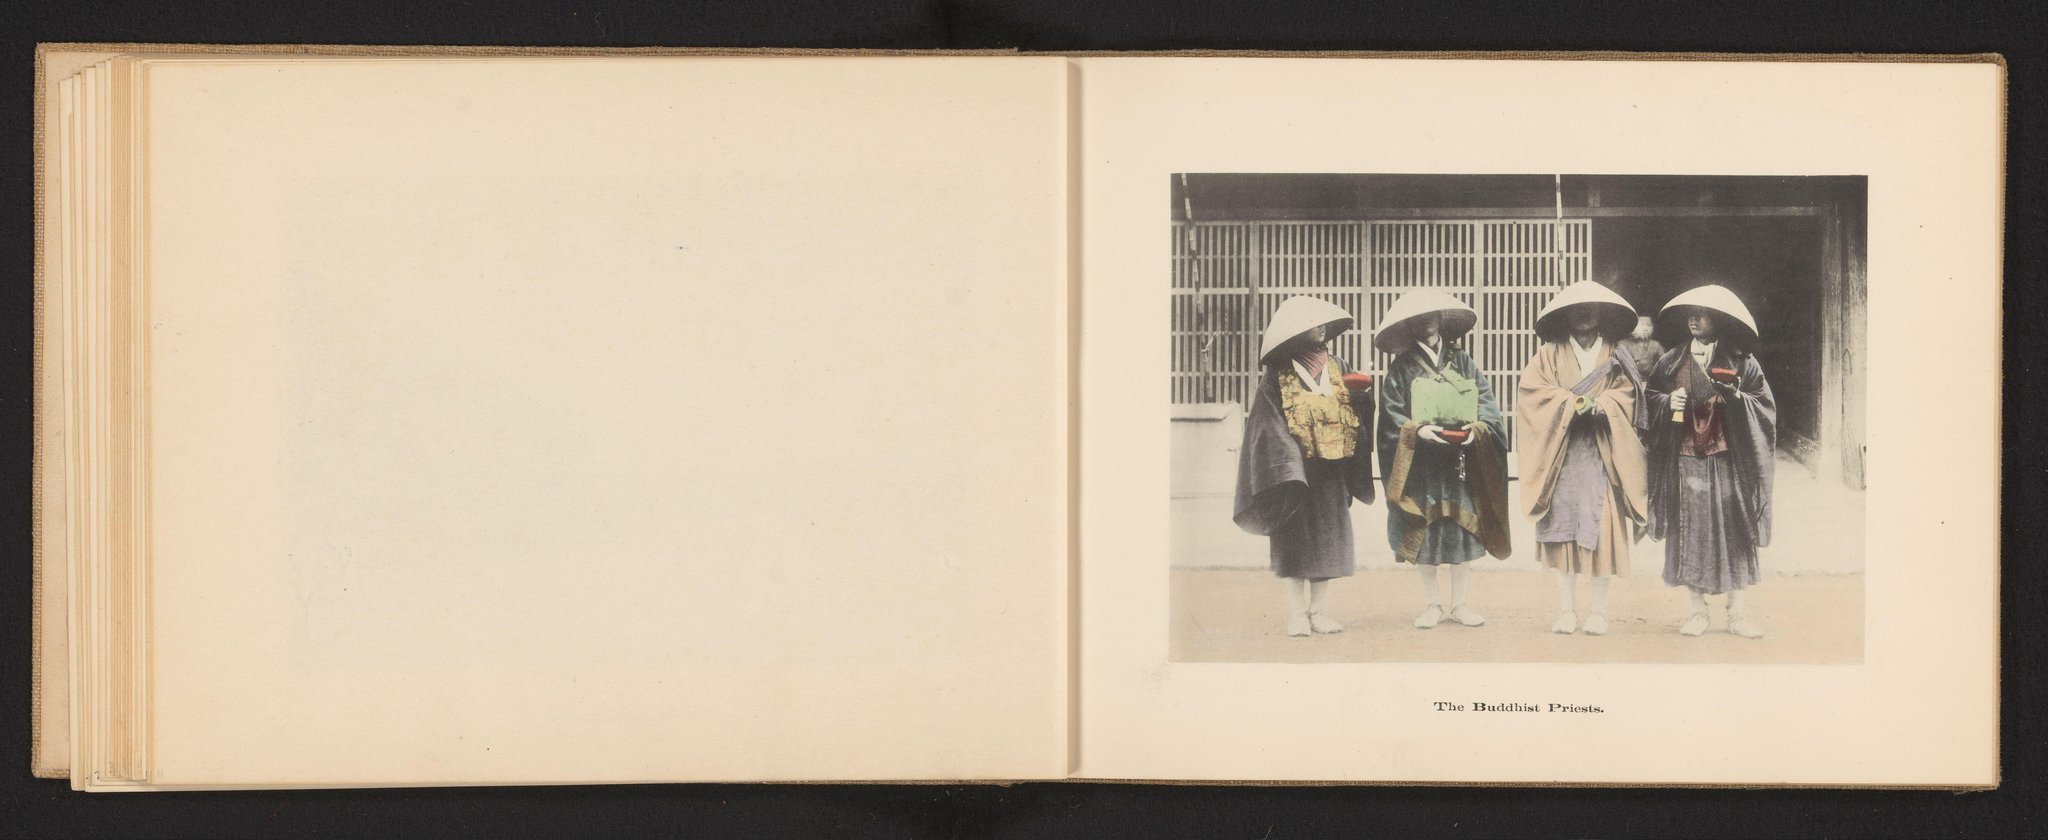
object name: photomechanical print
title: The Buddhist Priests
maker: kōzaburō tamamura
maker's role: fotograaf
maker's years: 1856-1923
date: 1895-1905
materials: paper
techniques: photograph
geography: japan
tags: priest ~ hinduism, buddhism, jainism, japan